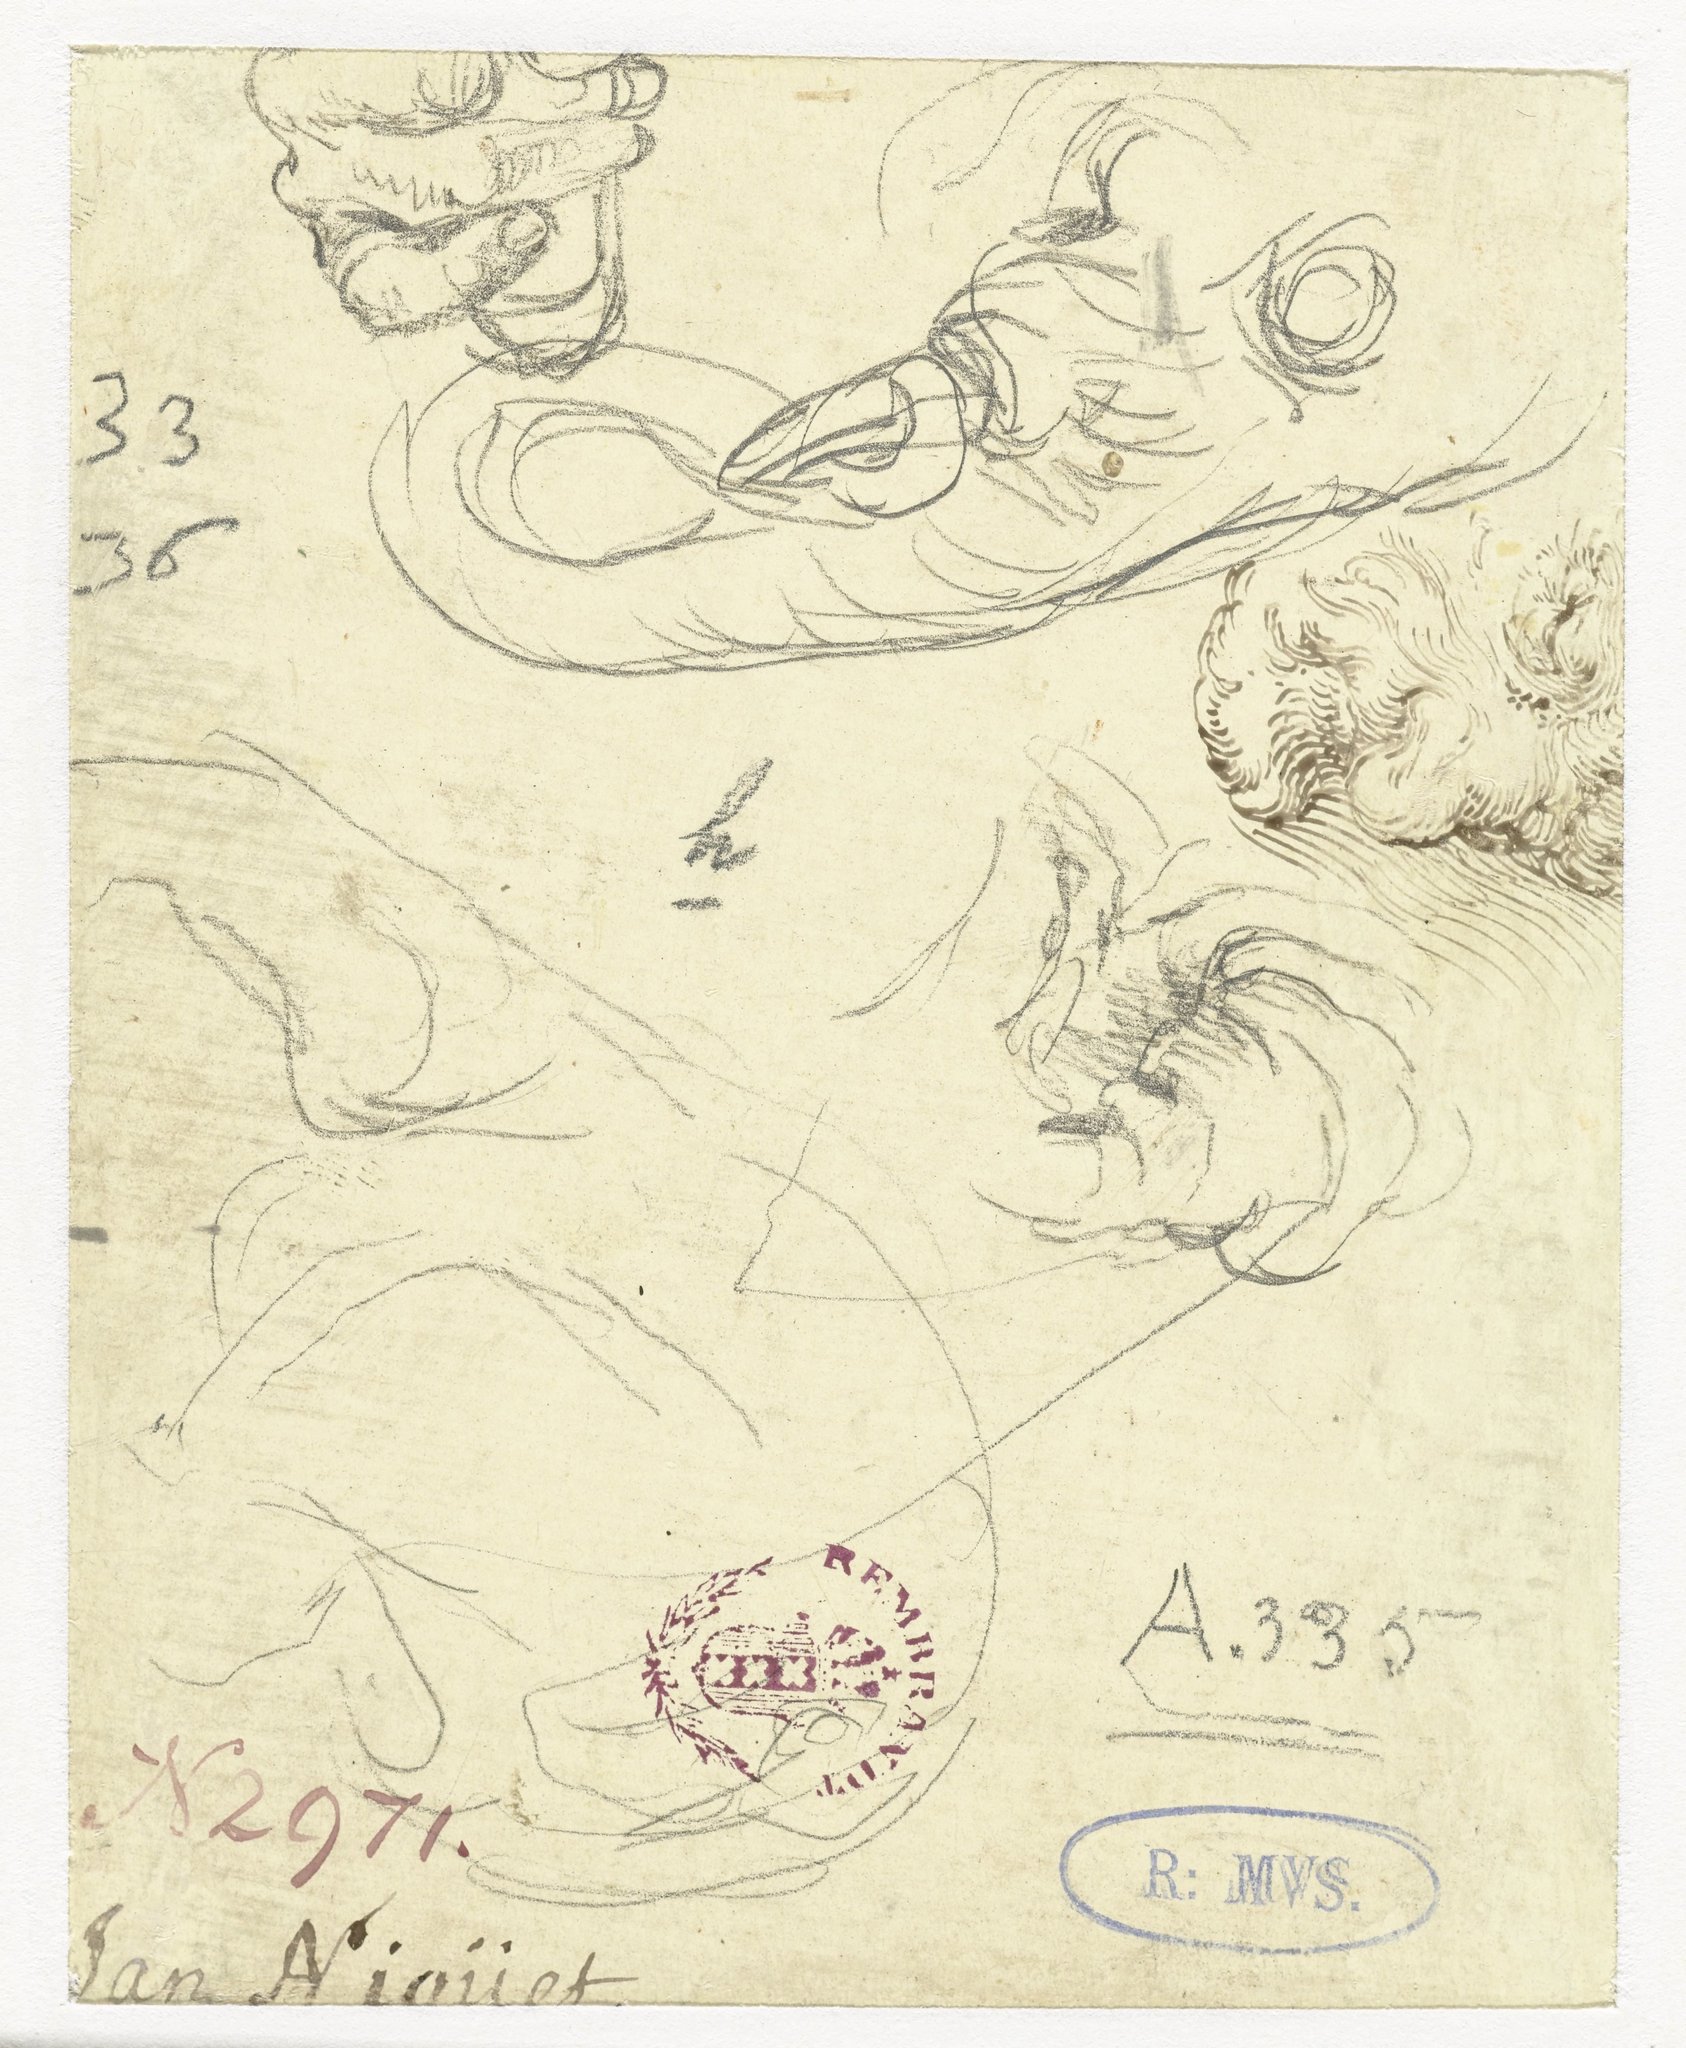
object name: drawing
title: Schetsen van olifant en hand en hoofd van een man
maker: hendrick goltzius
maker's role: draughtsman, painter, print maker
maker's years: 1558-1617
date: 1590-1595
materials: paper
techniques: pen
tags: trunked animals: elephant